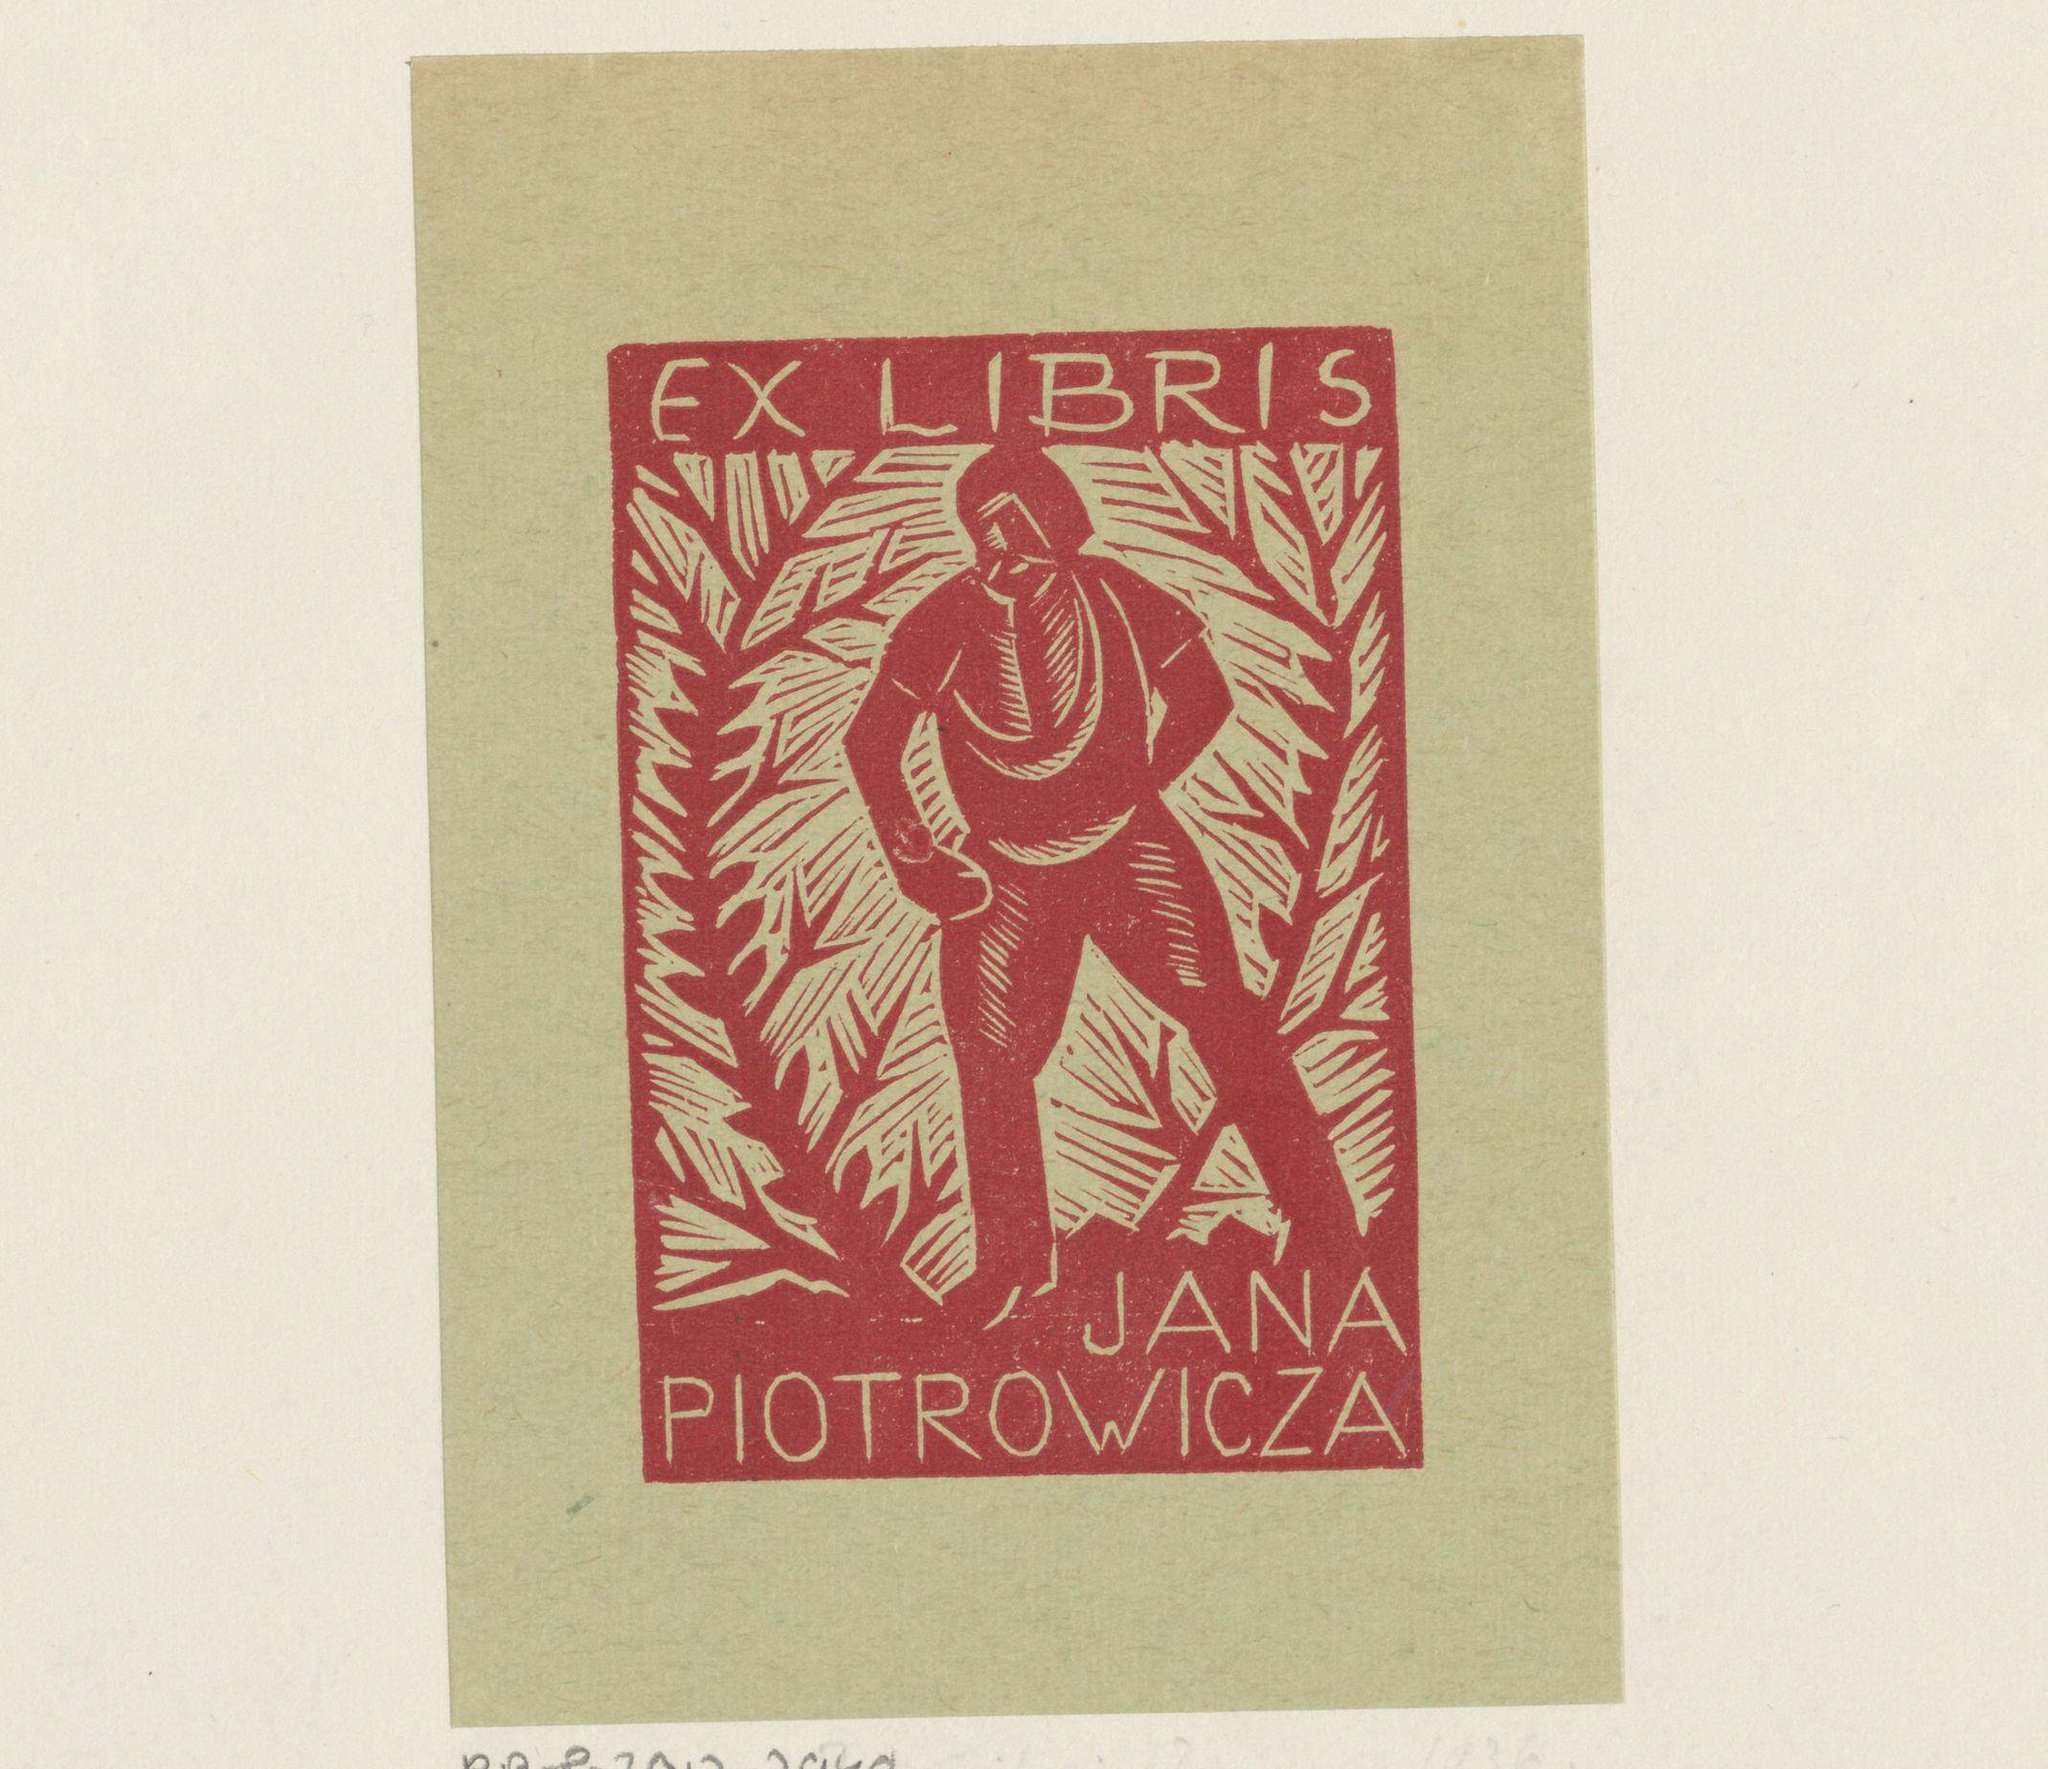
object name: bookplate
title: Ex libris Jana Piotrowicza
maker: stanisław zgaiński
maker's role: print maker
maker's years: 1907-1944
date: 1936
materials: paper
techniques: woodcut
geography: poland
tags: standing figure, sowing